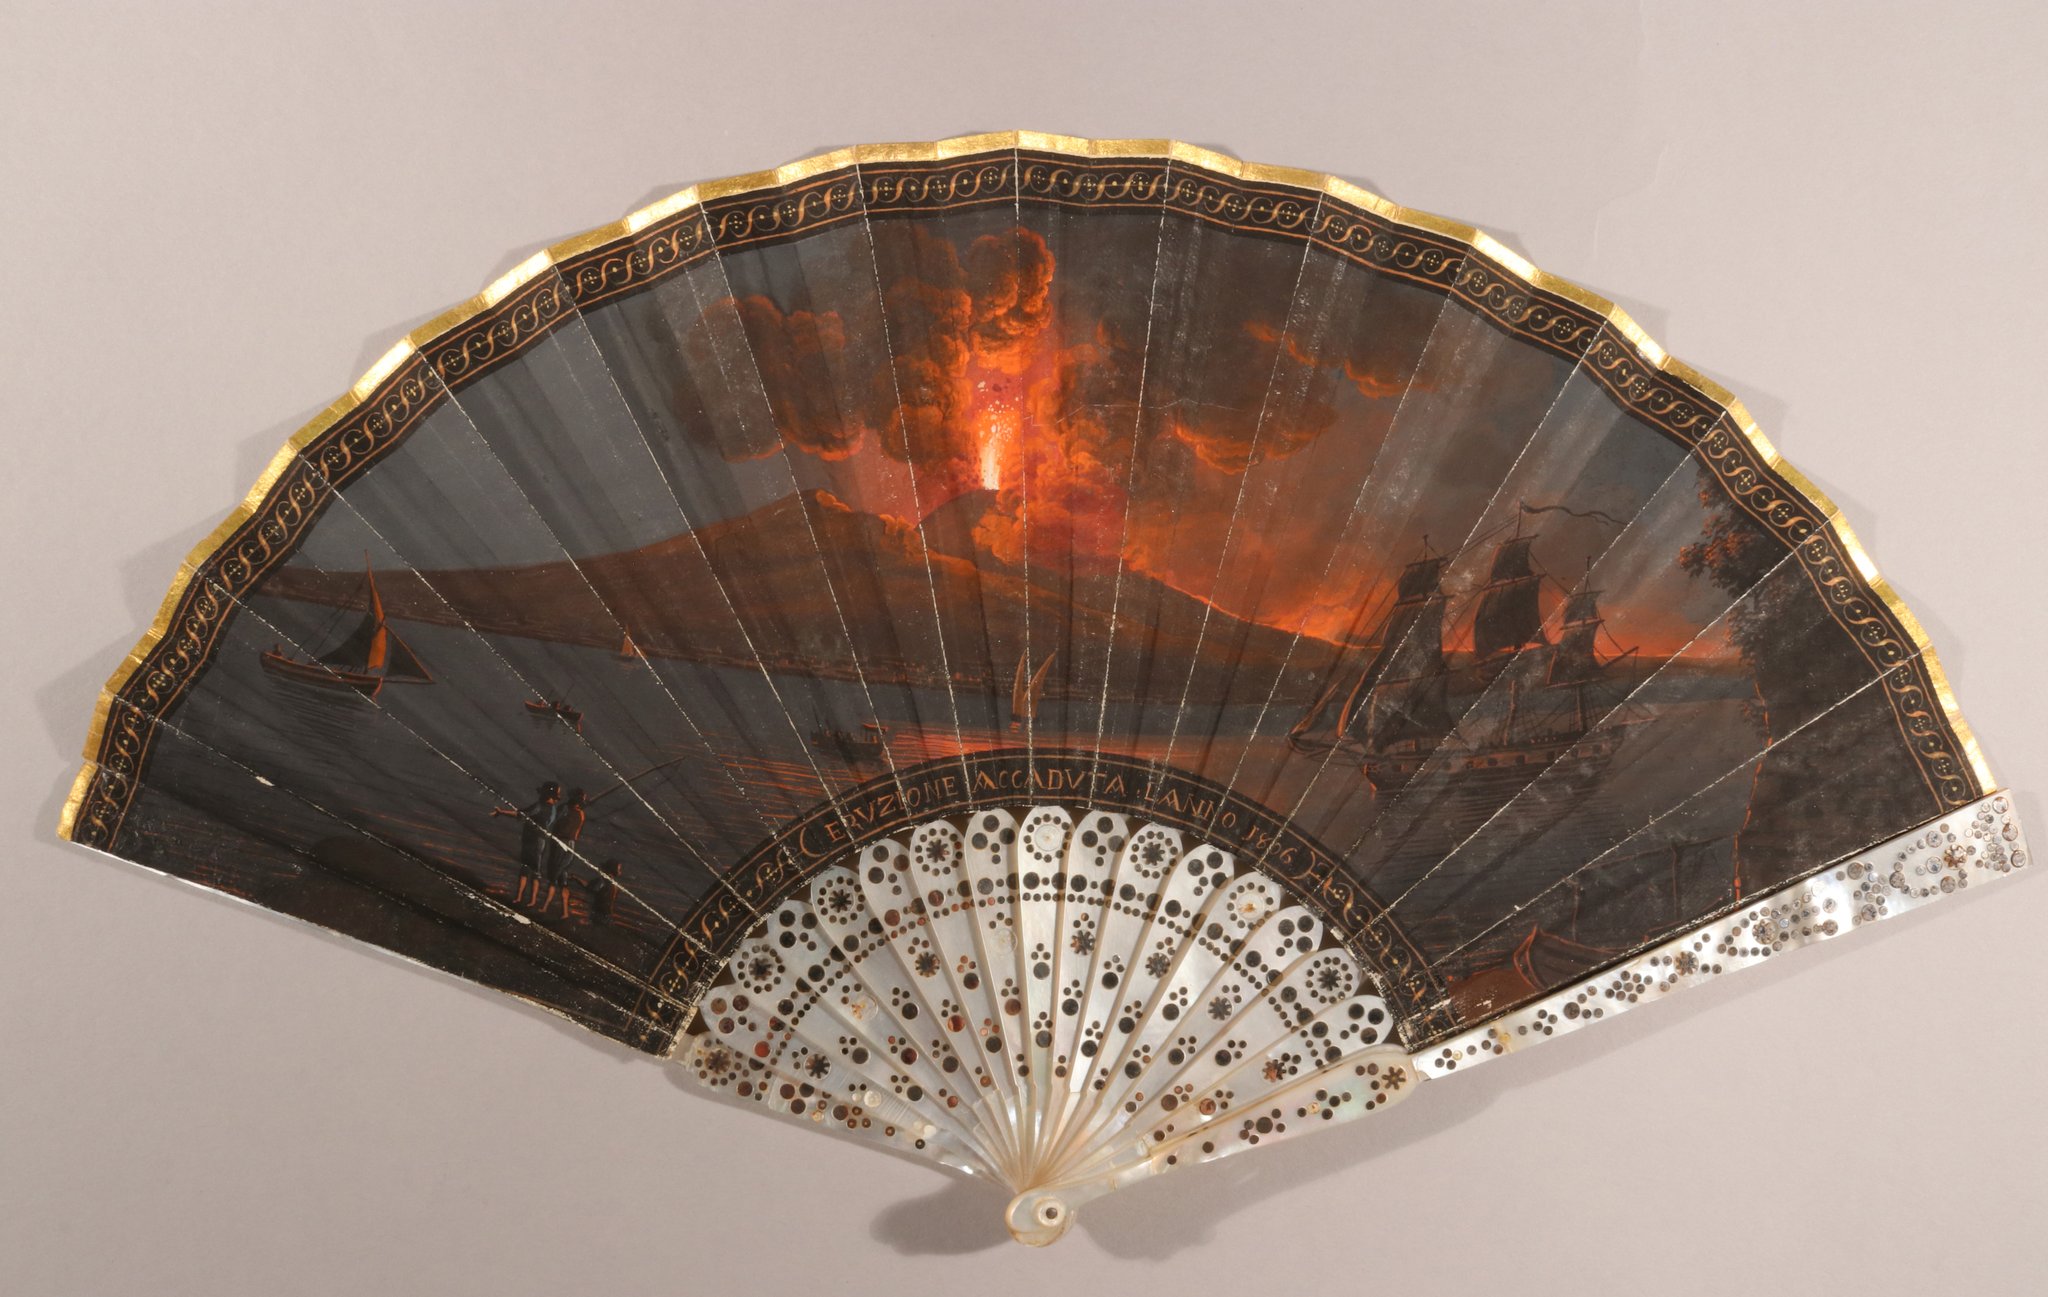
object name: fan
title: Folding Fan with a Representation of the 1806 Eruption of Mount Vesuvius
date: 1815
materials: gouache, mother of pearl, parchment, watercolor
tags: volcanoes,boats